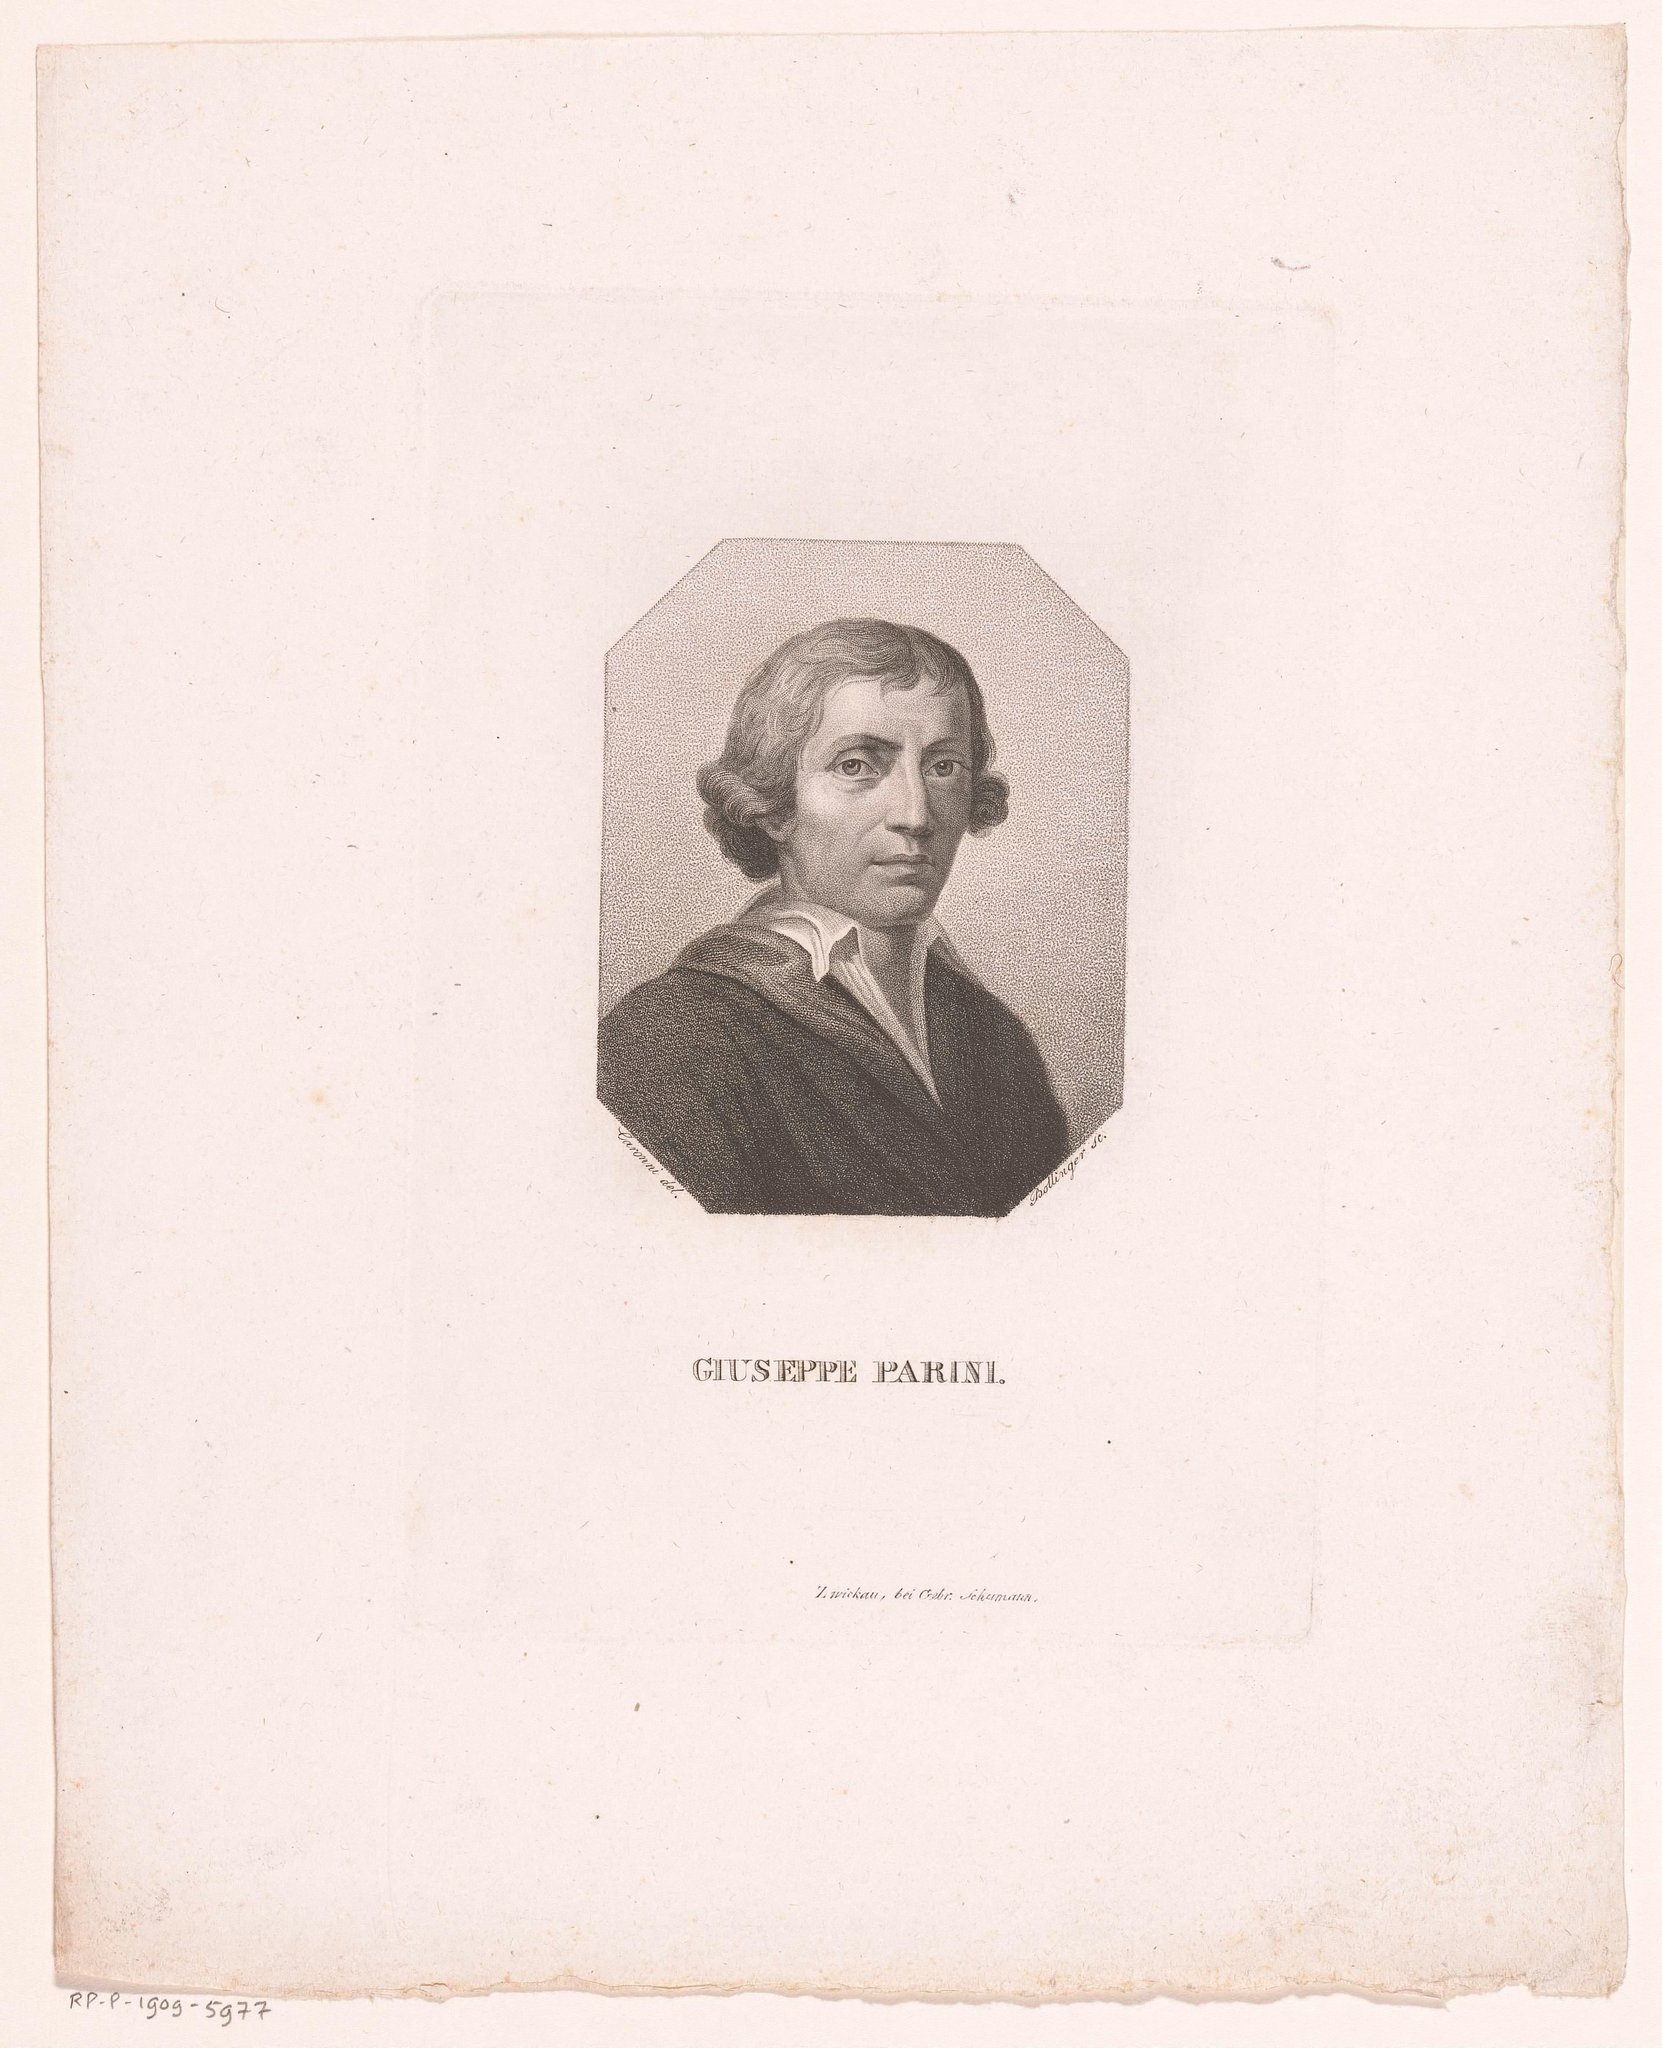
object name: print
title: Bildnisse der berühmtesten Menschen aller Völker und Zeiten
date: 1818-1832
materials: paper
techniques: stippling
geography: zwickau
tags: historical persons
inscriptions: collector's mark: Lugt 2228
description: Prent gebruikt door de serie 'Bildnisse der berühmtesten Menschen aller Völker und Zeiten' van de gebroeders Schumann, uitgegeven in 1818-1832 te Zwickau.